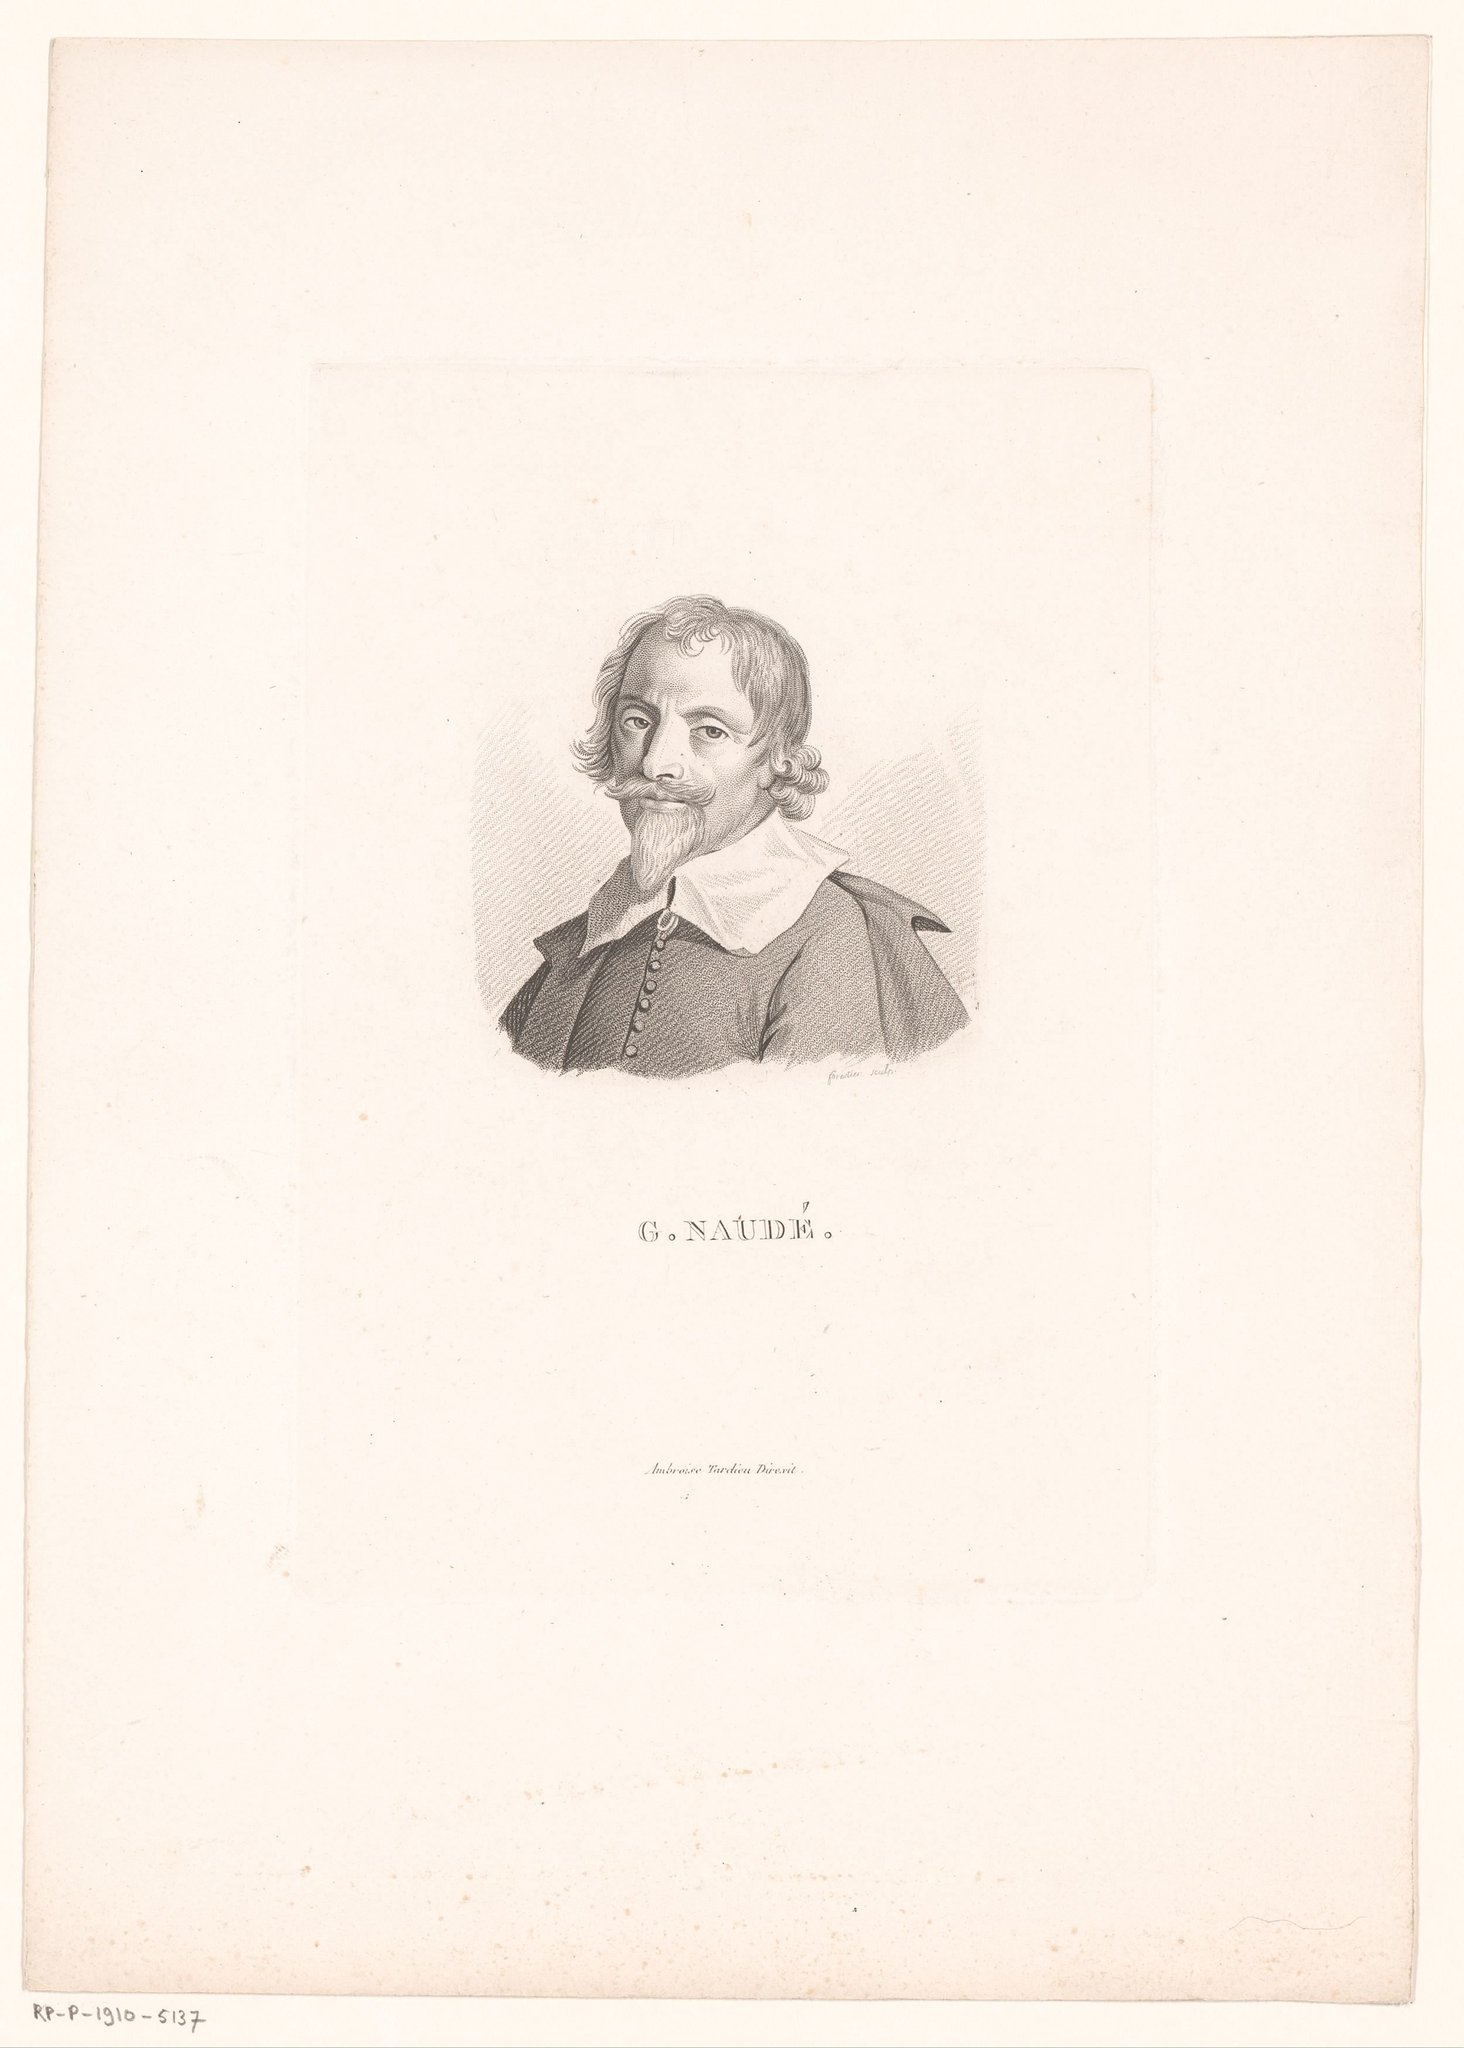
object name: book illustration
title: Mr. Auvity.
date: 1815-1817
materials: paper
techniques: etching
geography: france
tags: historical persons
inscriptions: collector's mark: Lugt 2228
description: Mogelijk prent uit: Frémy, Jacques Noël Marie. Croquis de portraits des personnages remarquables dans tous les genres, dessinés et gravés. Parijs: Jacques Noël Marie Frémy, 1815-1817.